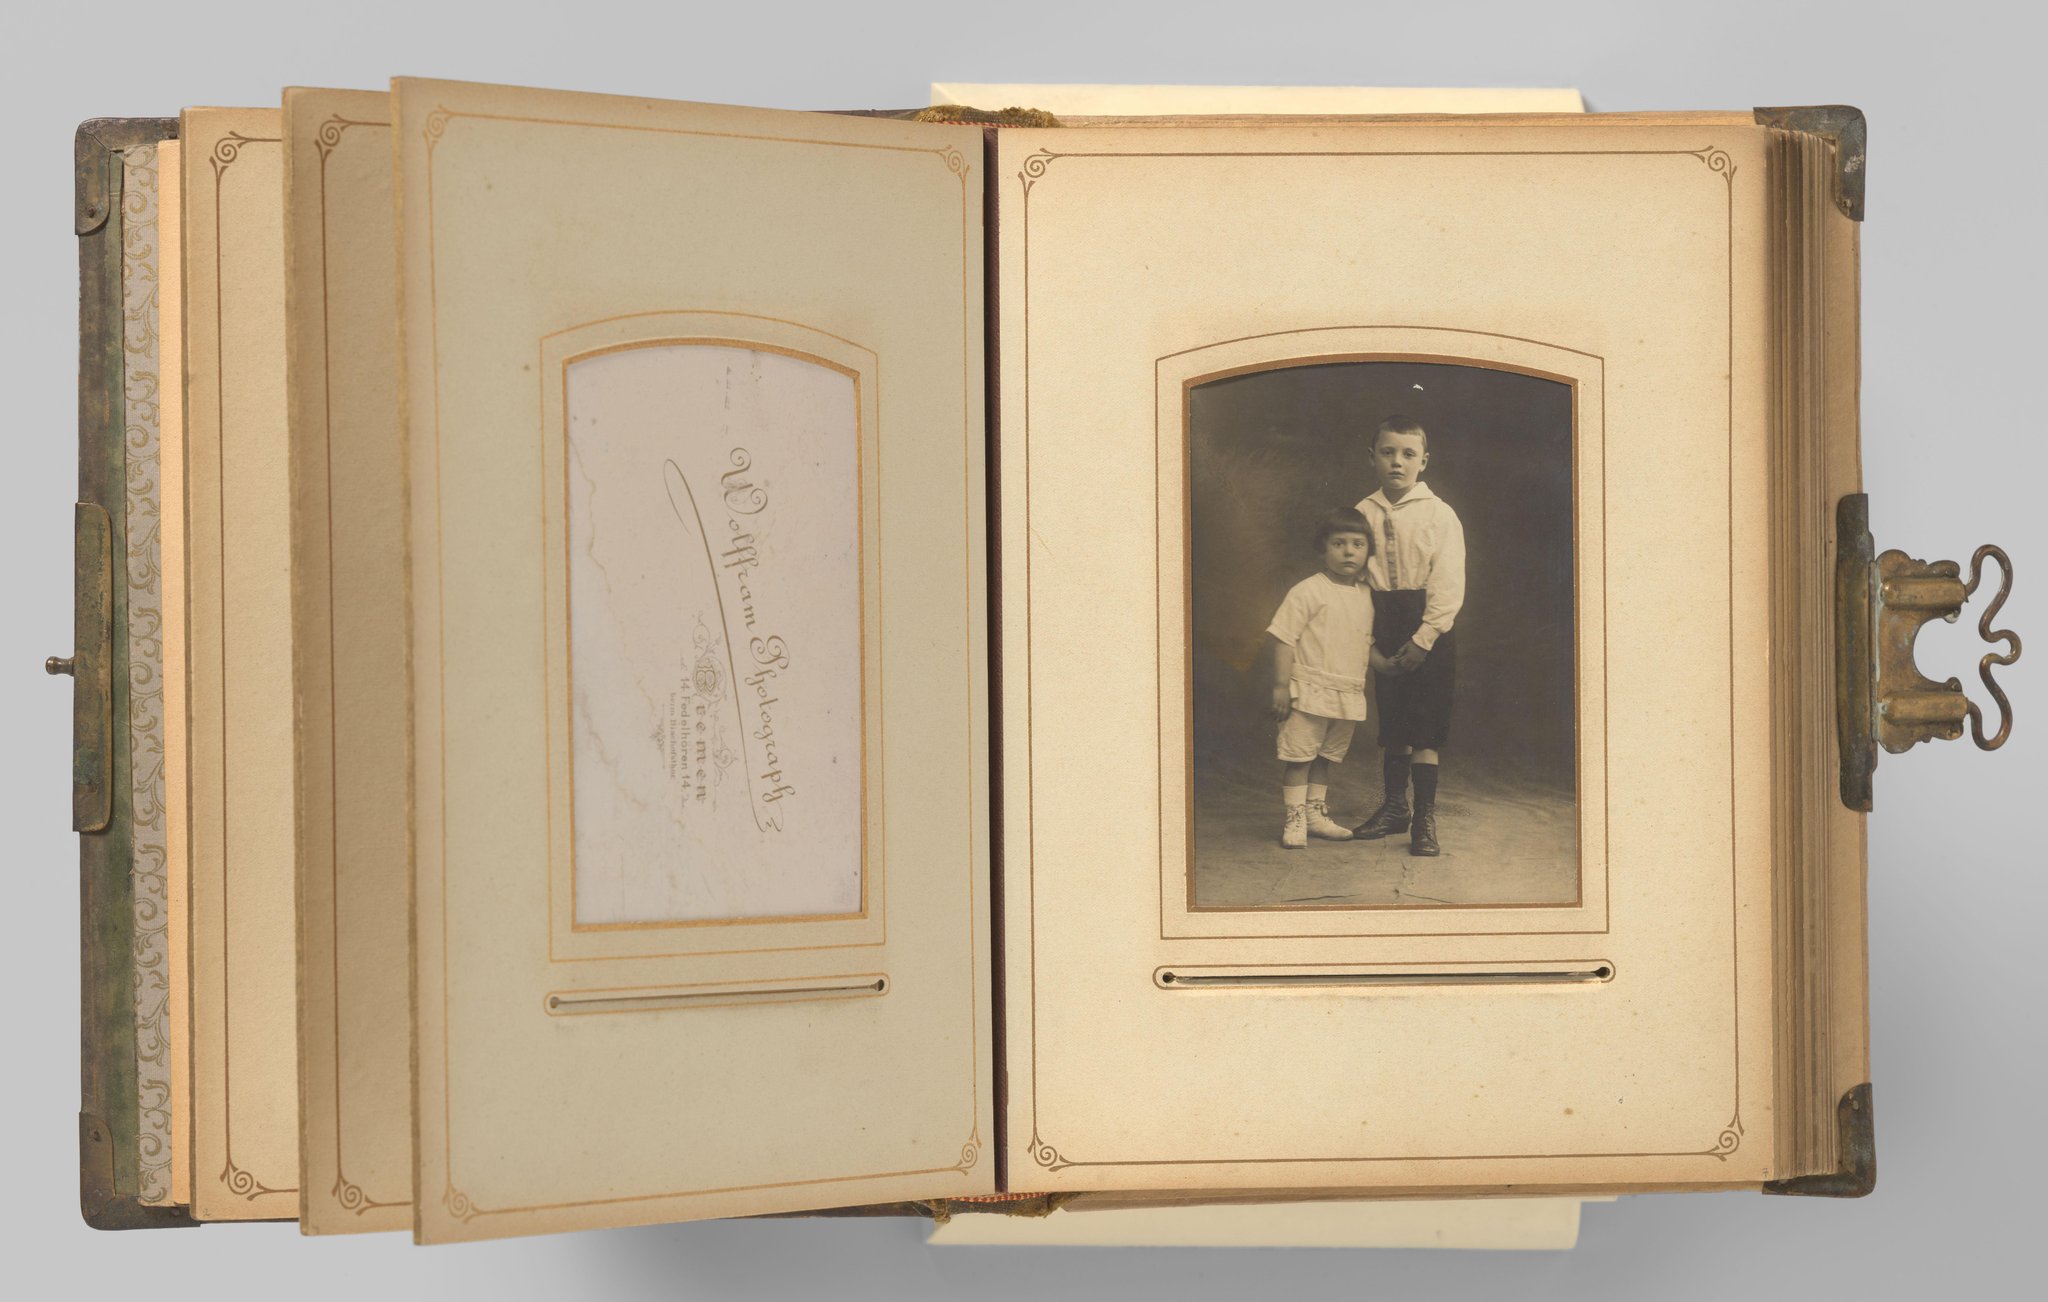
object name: album leaf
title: Portret van een staande jongen en een staand meisje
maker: Anonymous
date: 1900-1920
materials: cardboard, photographic support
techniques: gelatin silver print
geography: germany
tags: historical persons - bb - woman, boy (child between toddler and youth), historical persons, toddler (female)